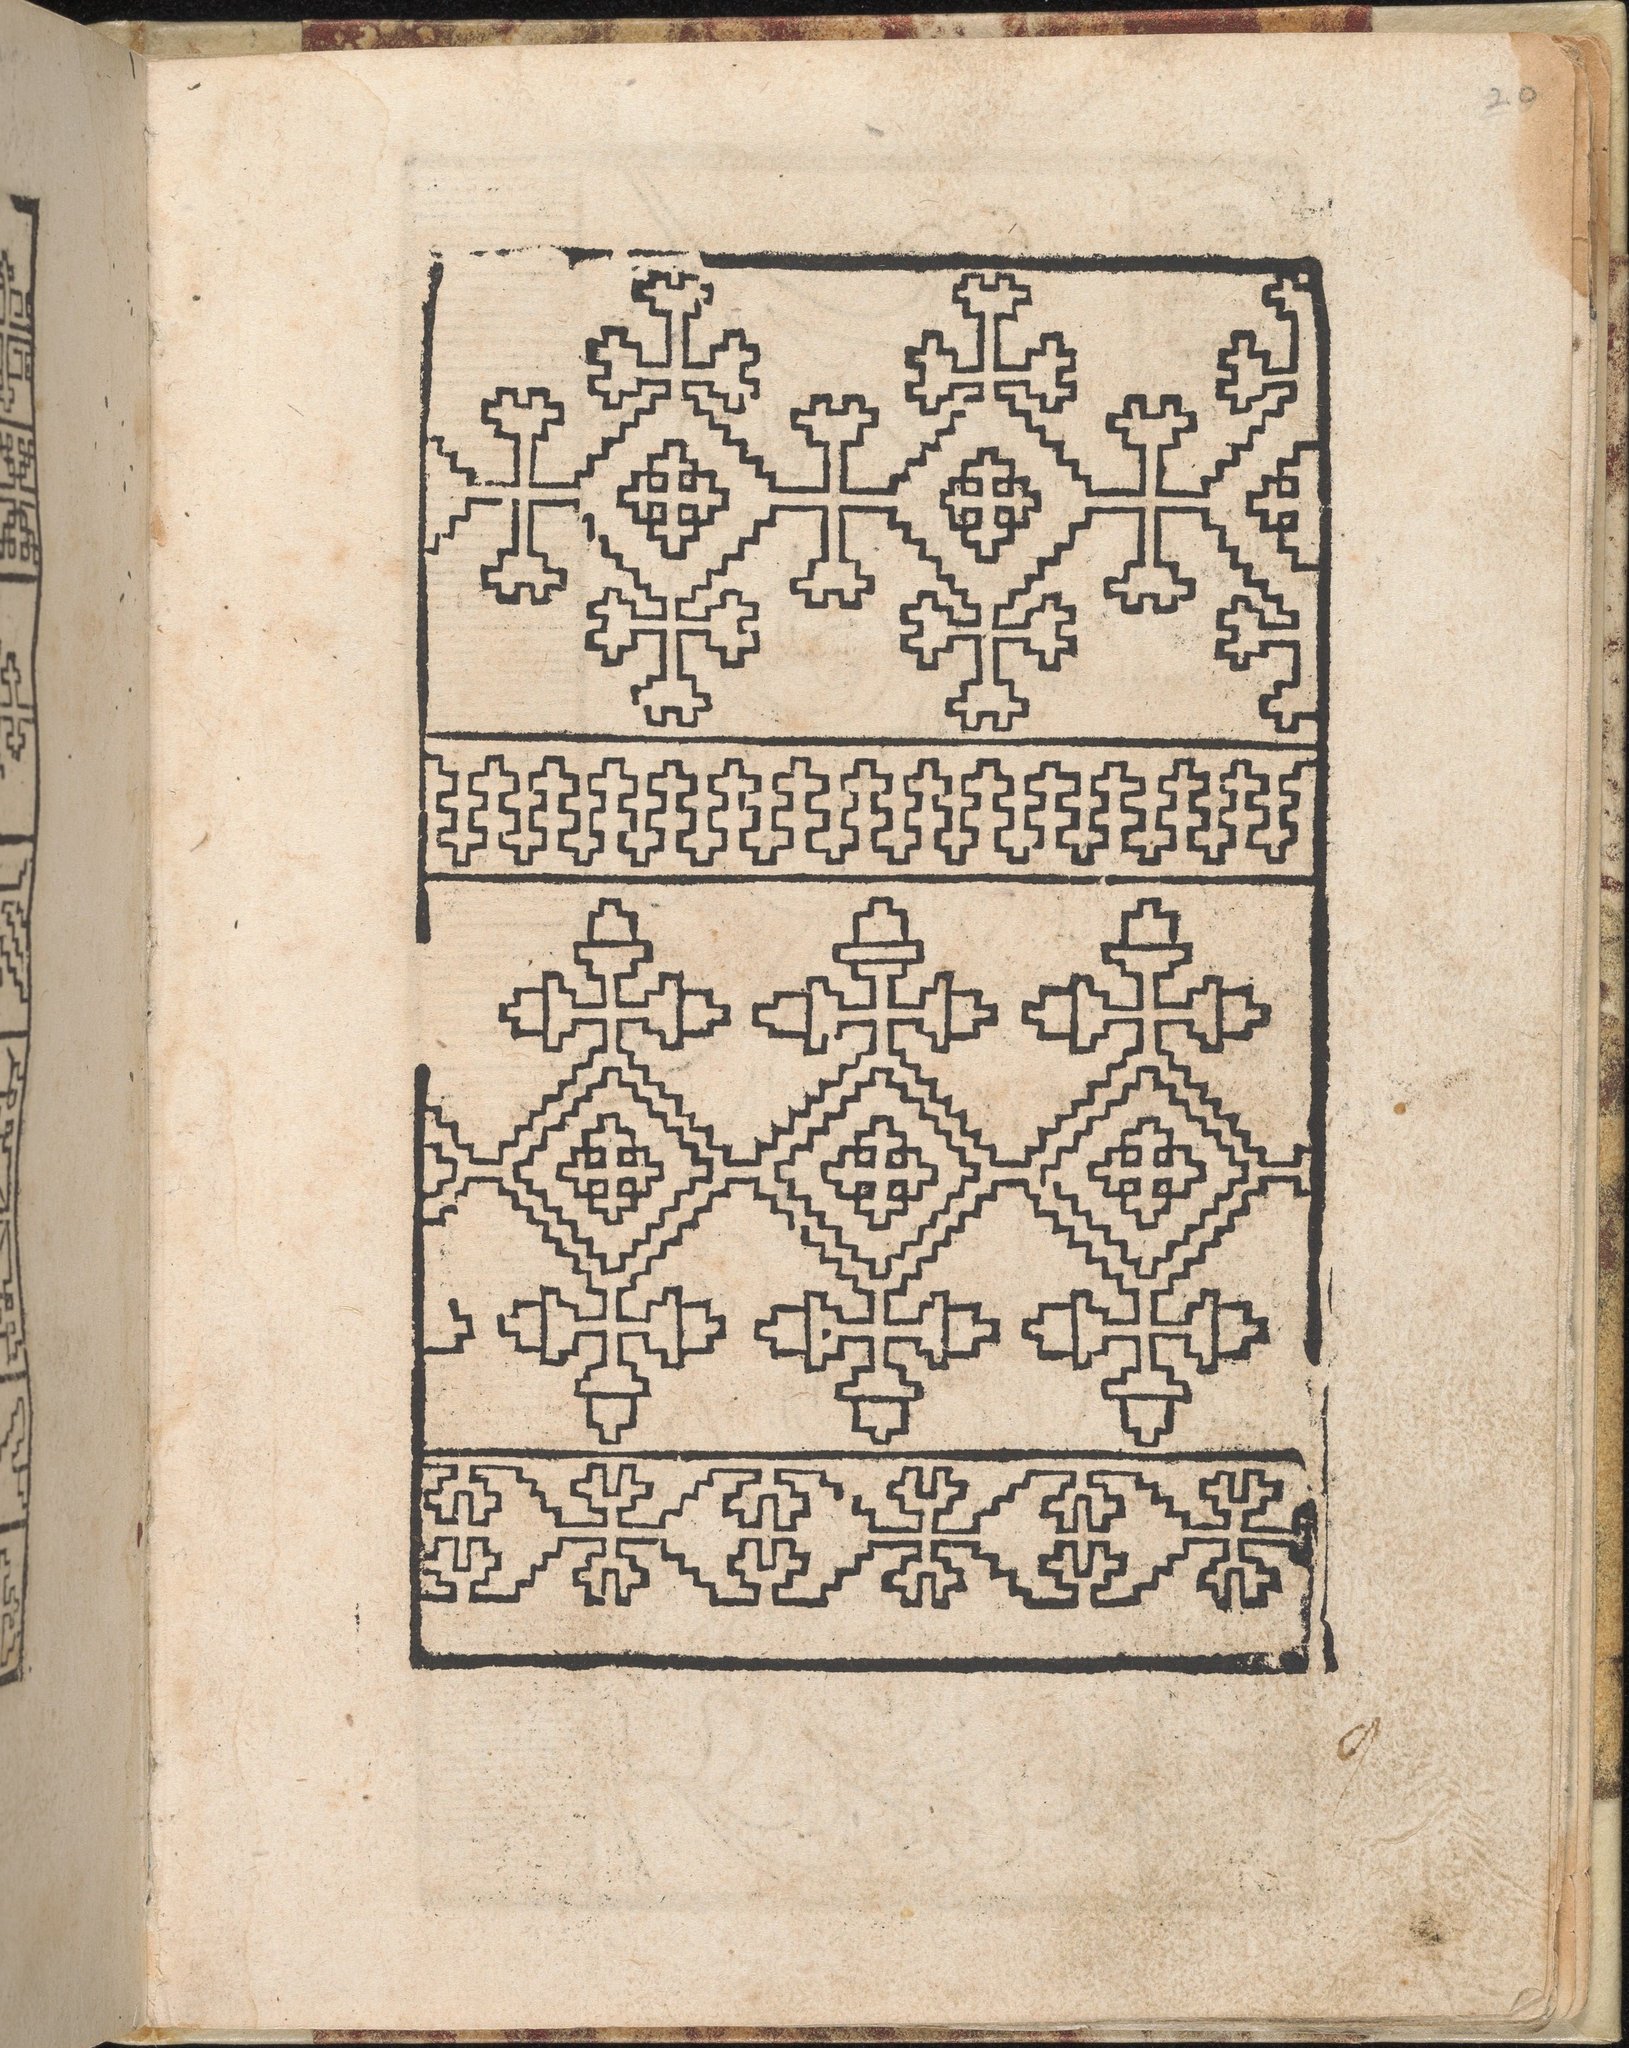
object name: book print ornament architecture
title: Ein new getruckt model Büchli...Page 20, recto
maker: johann schönsperger the younger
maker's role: publisher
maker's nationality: german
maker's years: 1490-1550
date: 1529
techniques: woodcut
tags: ornament